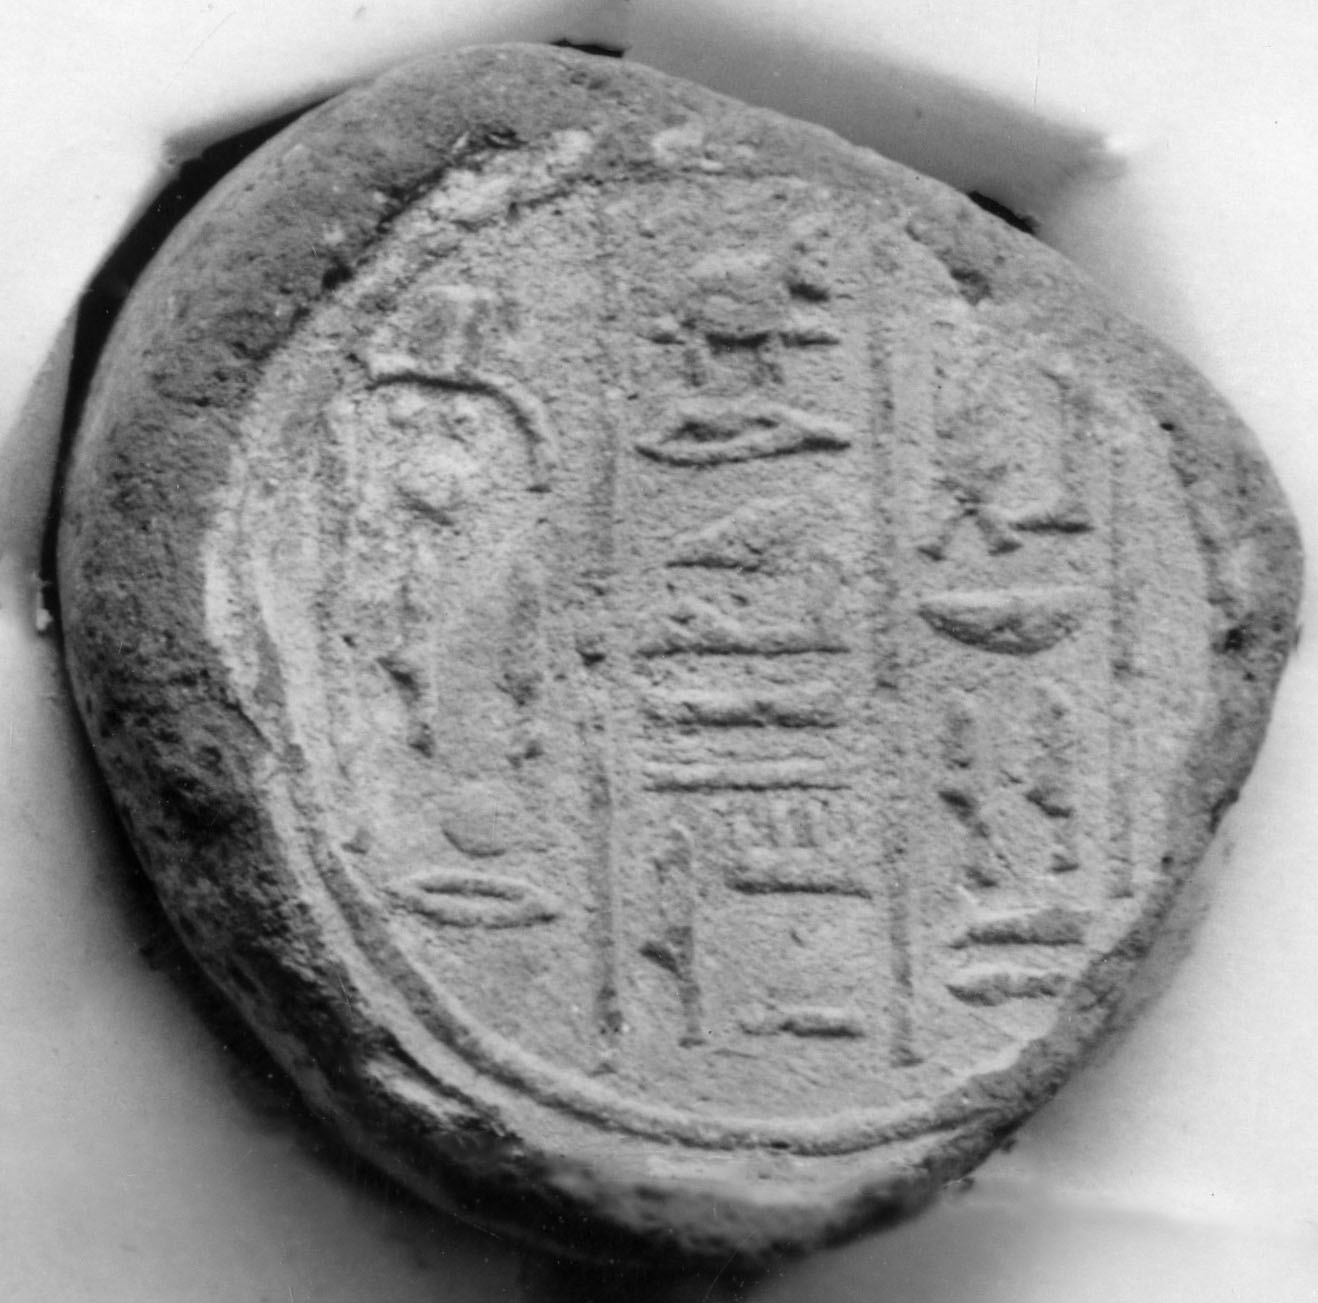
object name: cone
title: Funerary Cone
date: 1550-1295 BCE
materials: pottery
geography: egypt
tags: hieroglyphs